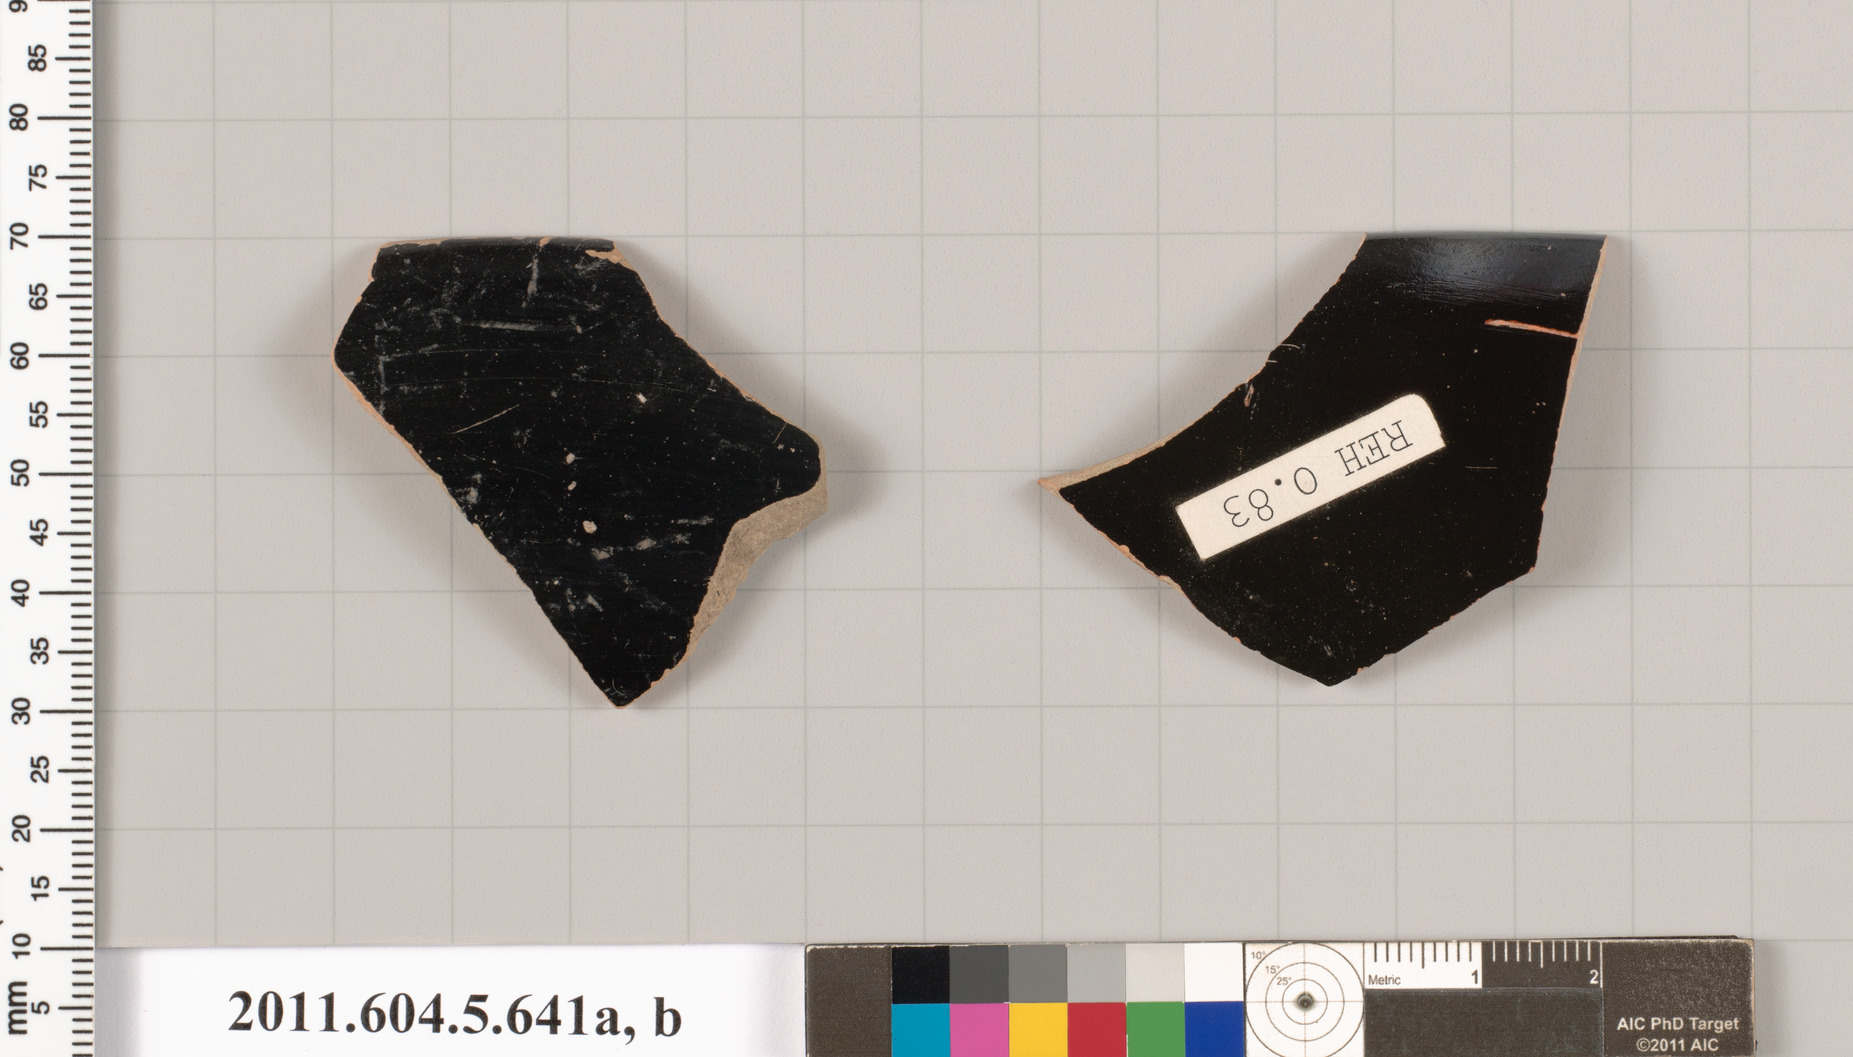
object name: kylix fragment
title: Terracotta rim fragments of kylikes (drinking cups)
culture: greek, attic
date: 600-401 BCE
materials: terracotta